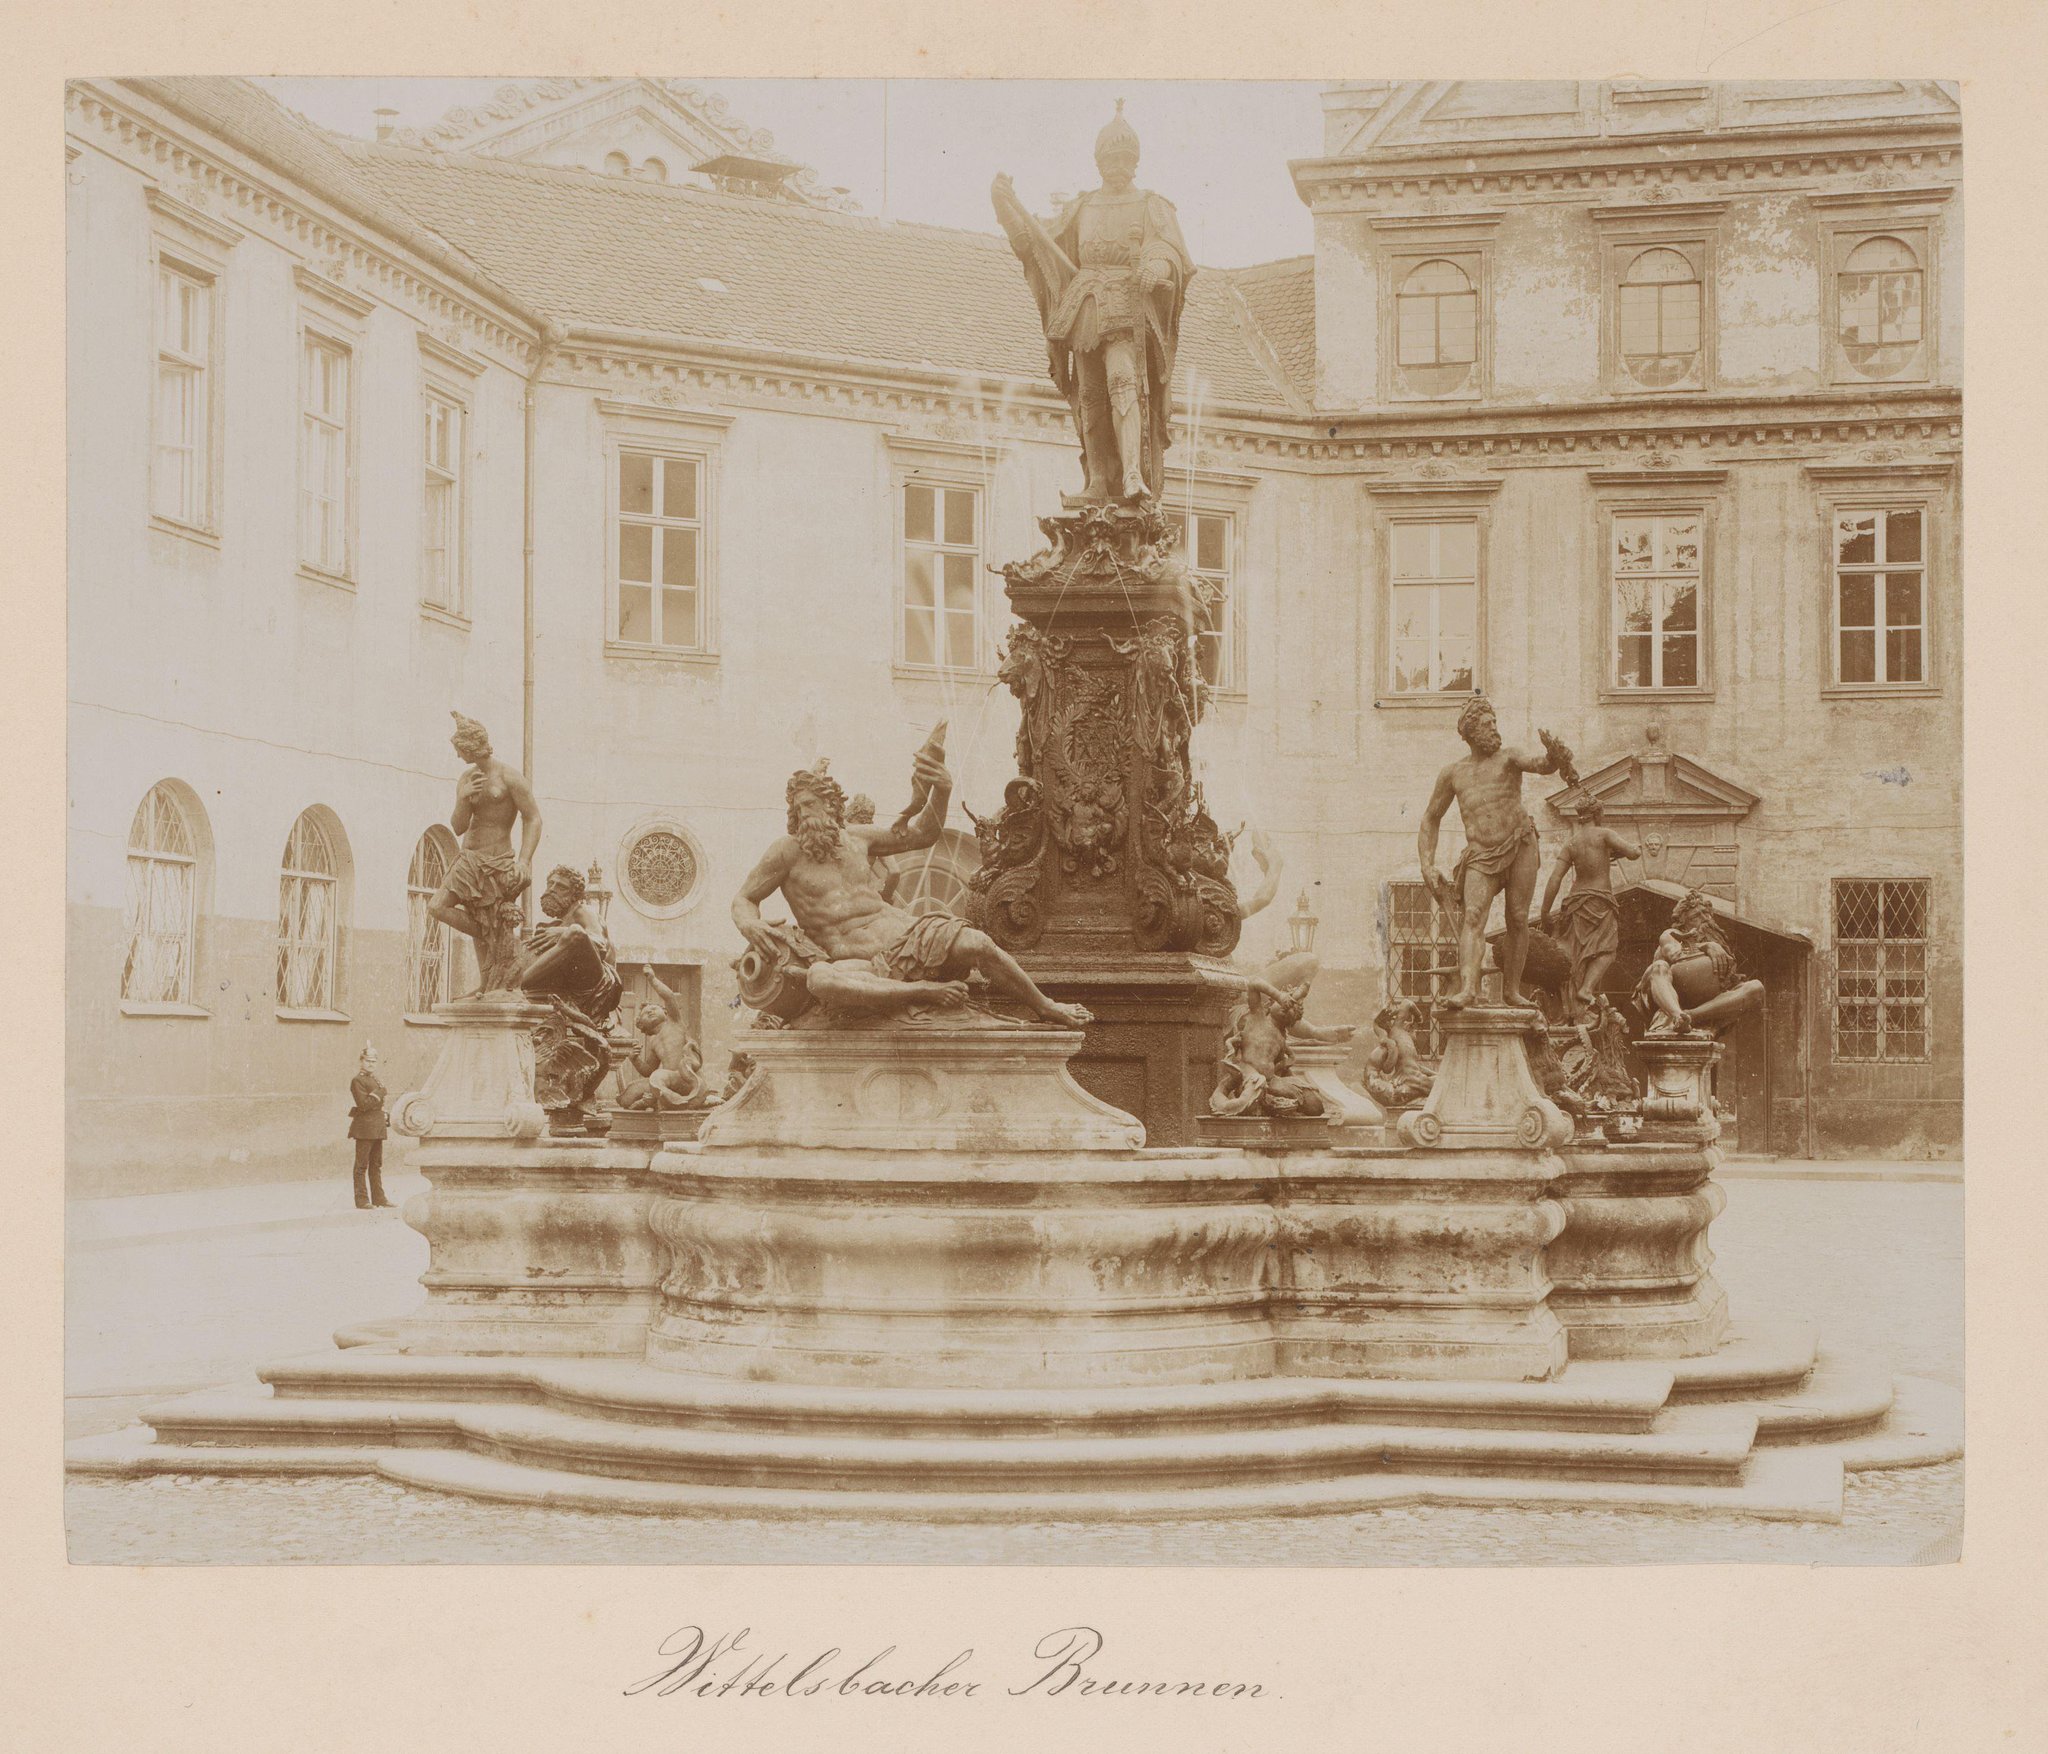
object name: photograph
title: Wittelsbacher Brunnen, München, Duitsland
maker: Anonymous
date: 1880-1910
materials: cardboard, photographic support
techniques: collodion silver print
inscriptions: inscription: ‘Wittelsbacher Brunnen.’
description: Wittelsbacher Brunnen zijn ook een vrij algemene naam voor bronnen/waterputten.